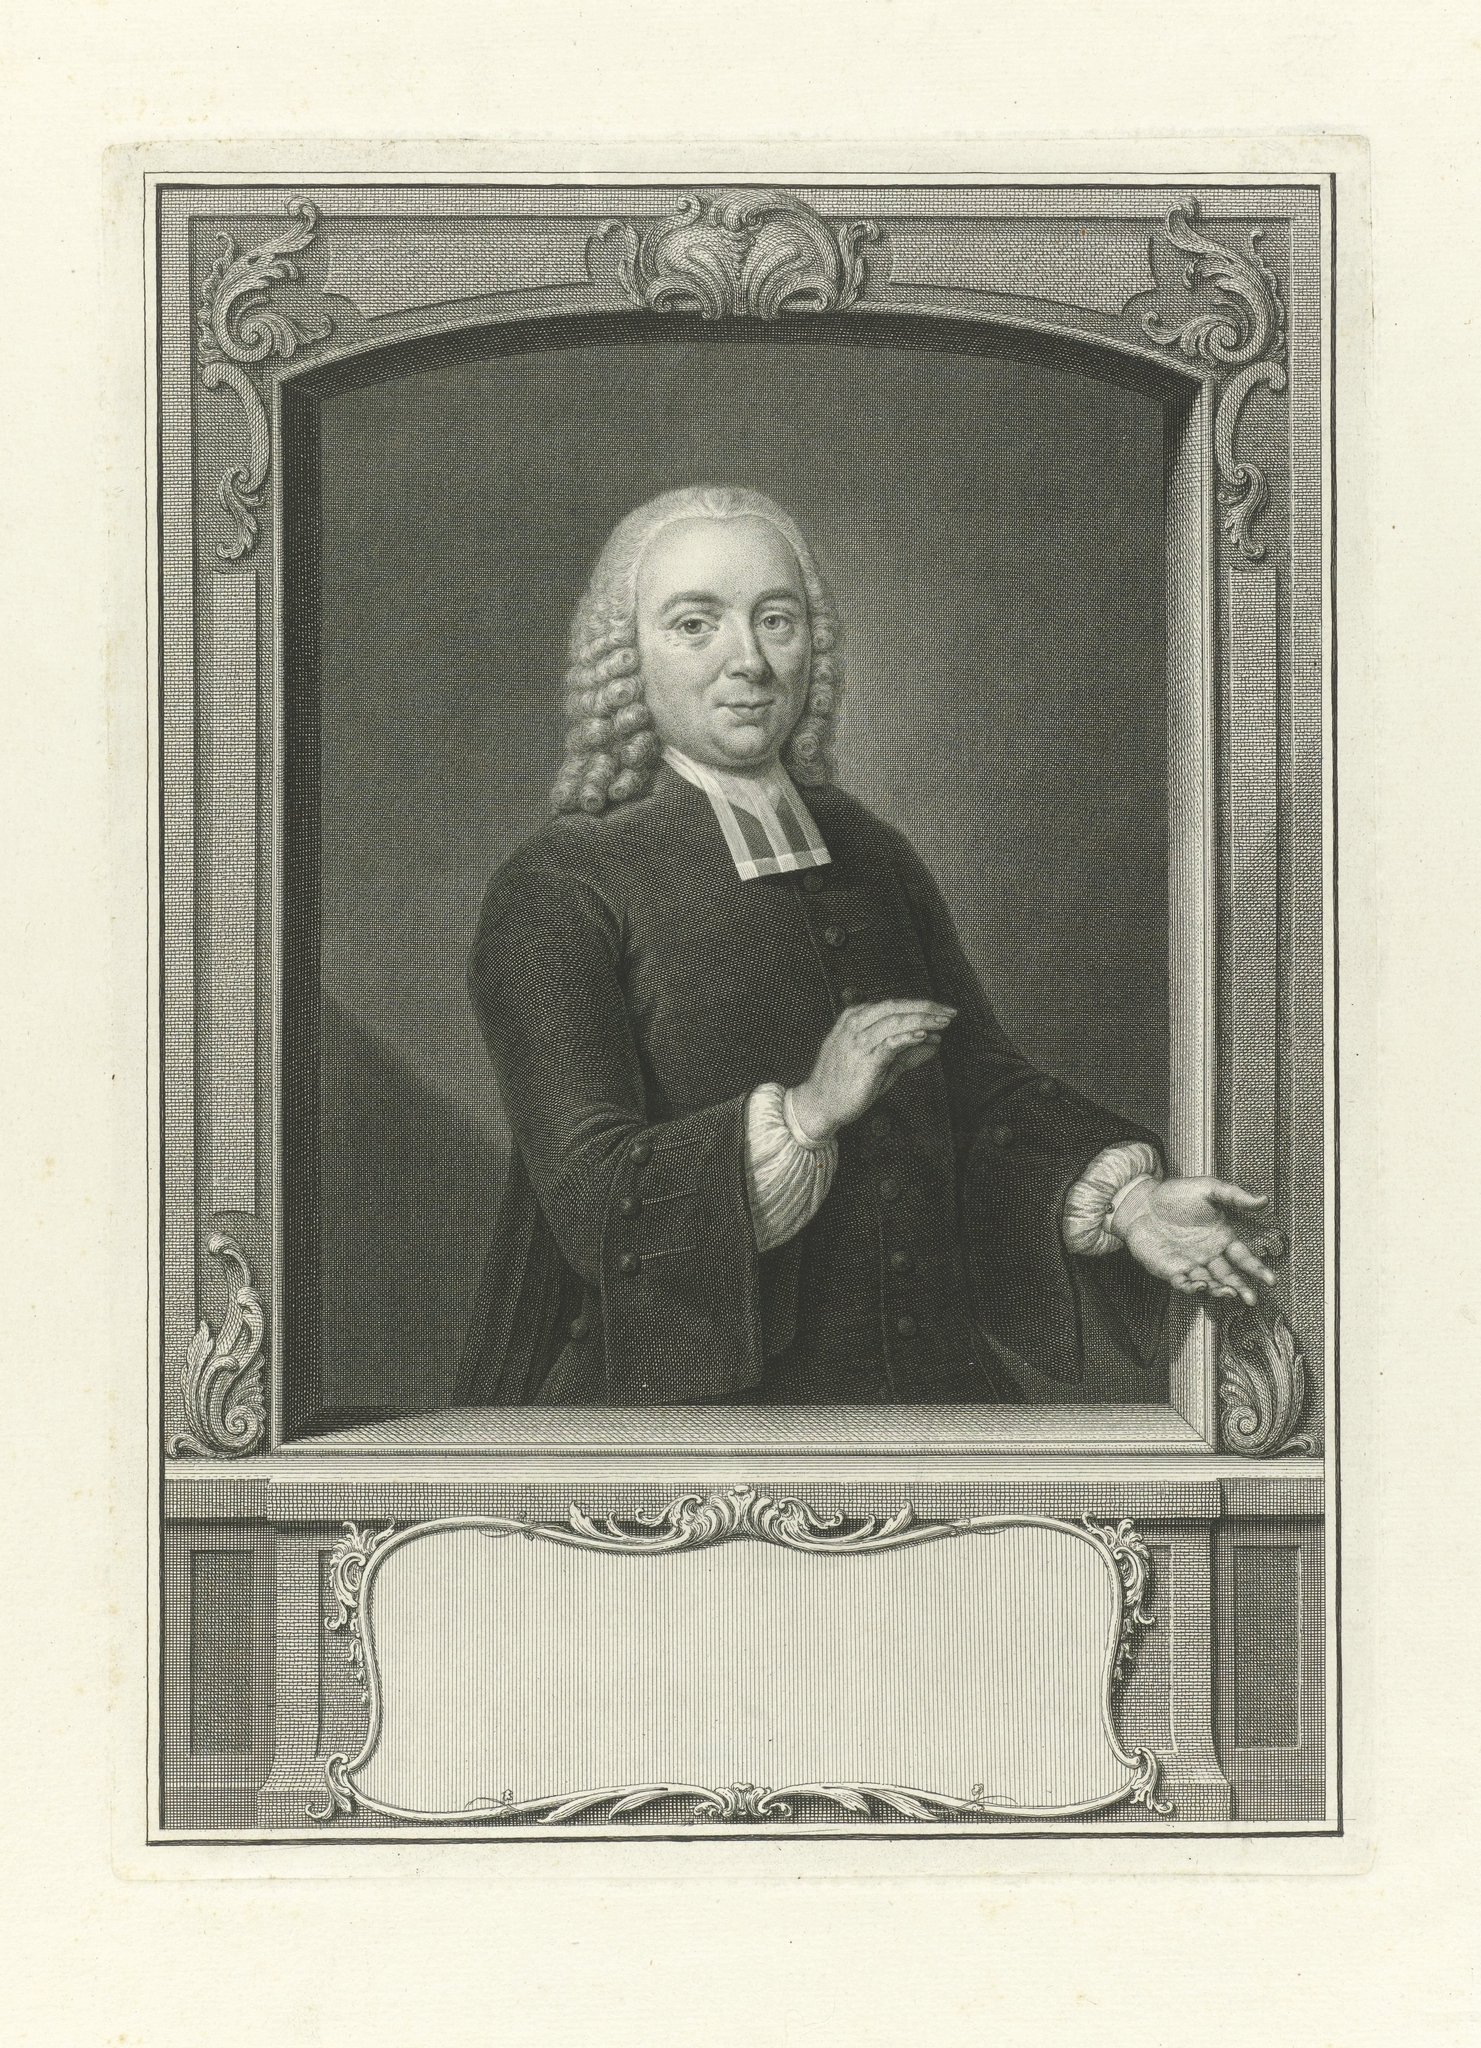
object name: print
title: Portret van Willem van den Broek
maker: pieter tanjé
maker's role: draughtsman, print maker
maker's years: 1706-1761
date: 1756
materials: paper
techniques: engraving, etching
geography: amsterdam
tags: predikant, willem van den broek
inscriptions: collector's mark: Lugt 240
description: Portret van Willem van den Broek, predikant te Amsterdam, op 39-jarige leeftijd.